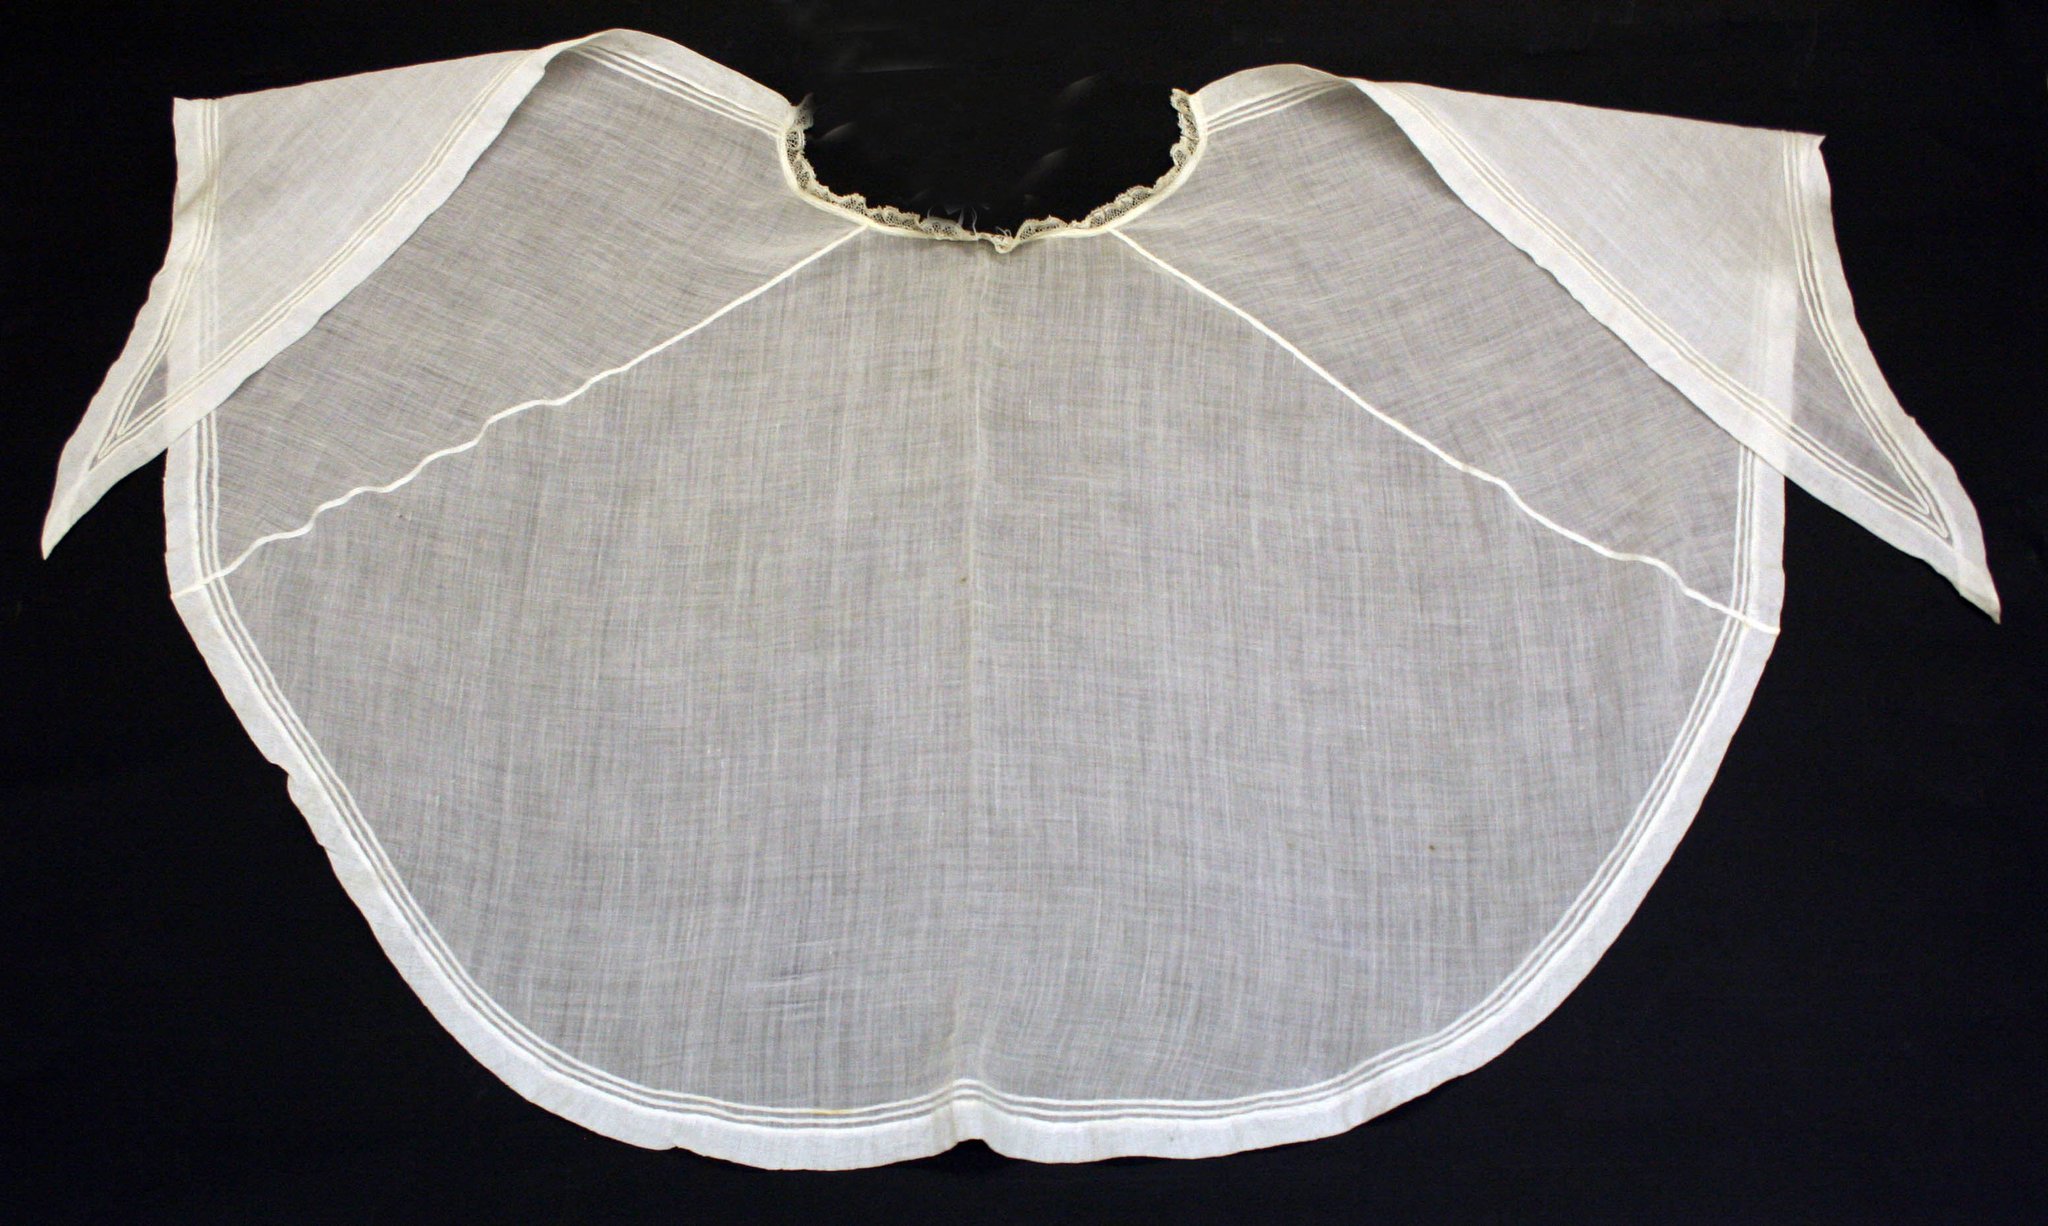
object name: collar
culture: american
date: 1830-1840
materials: cotton